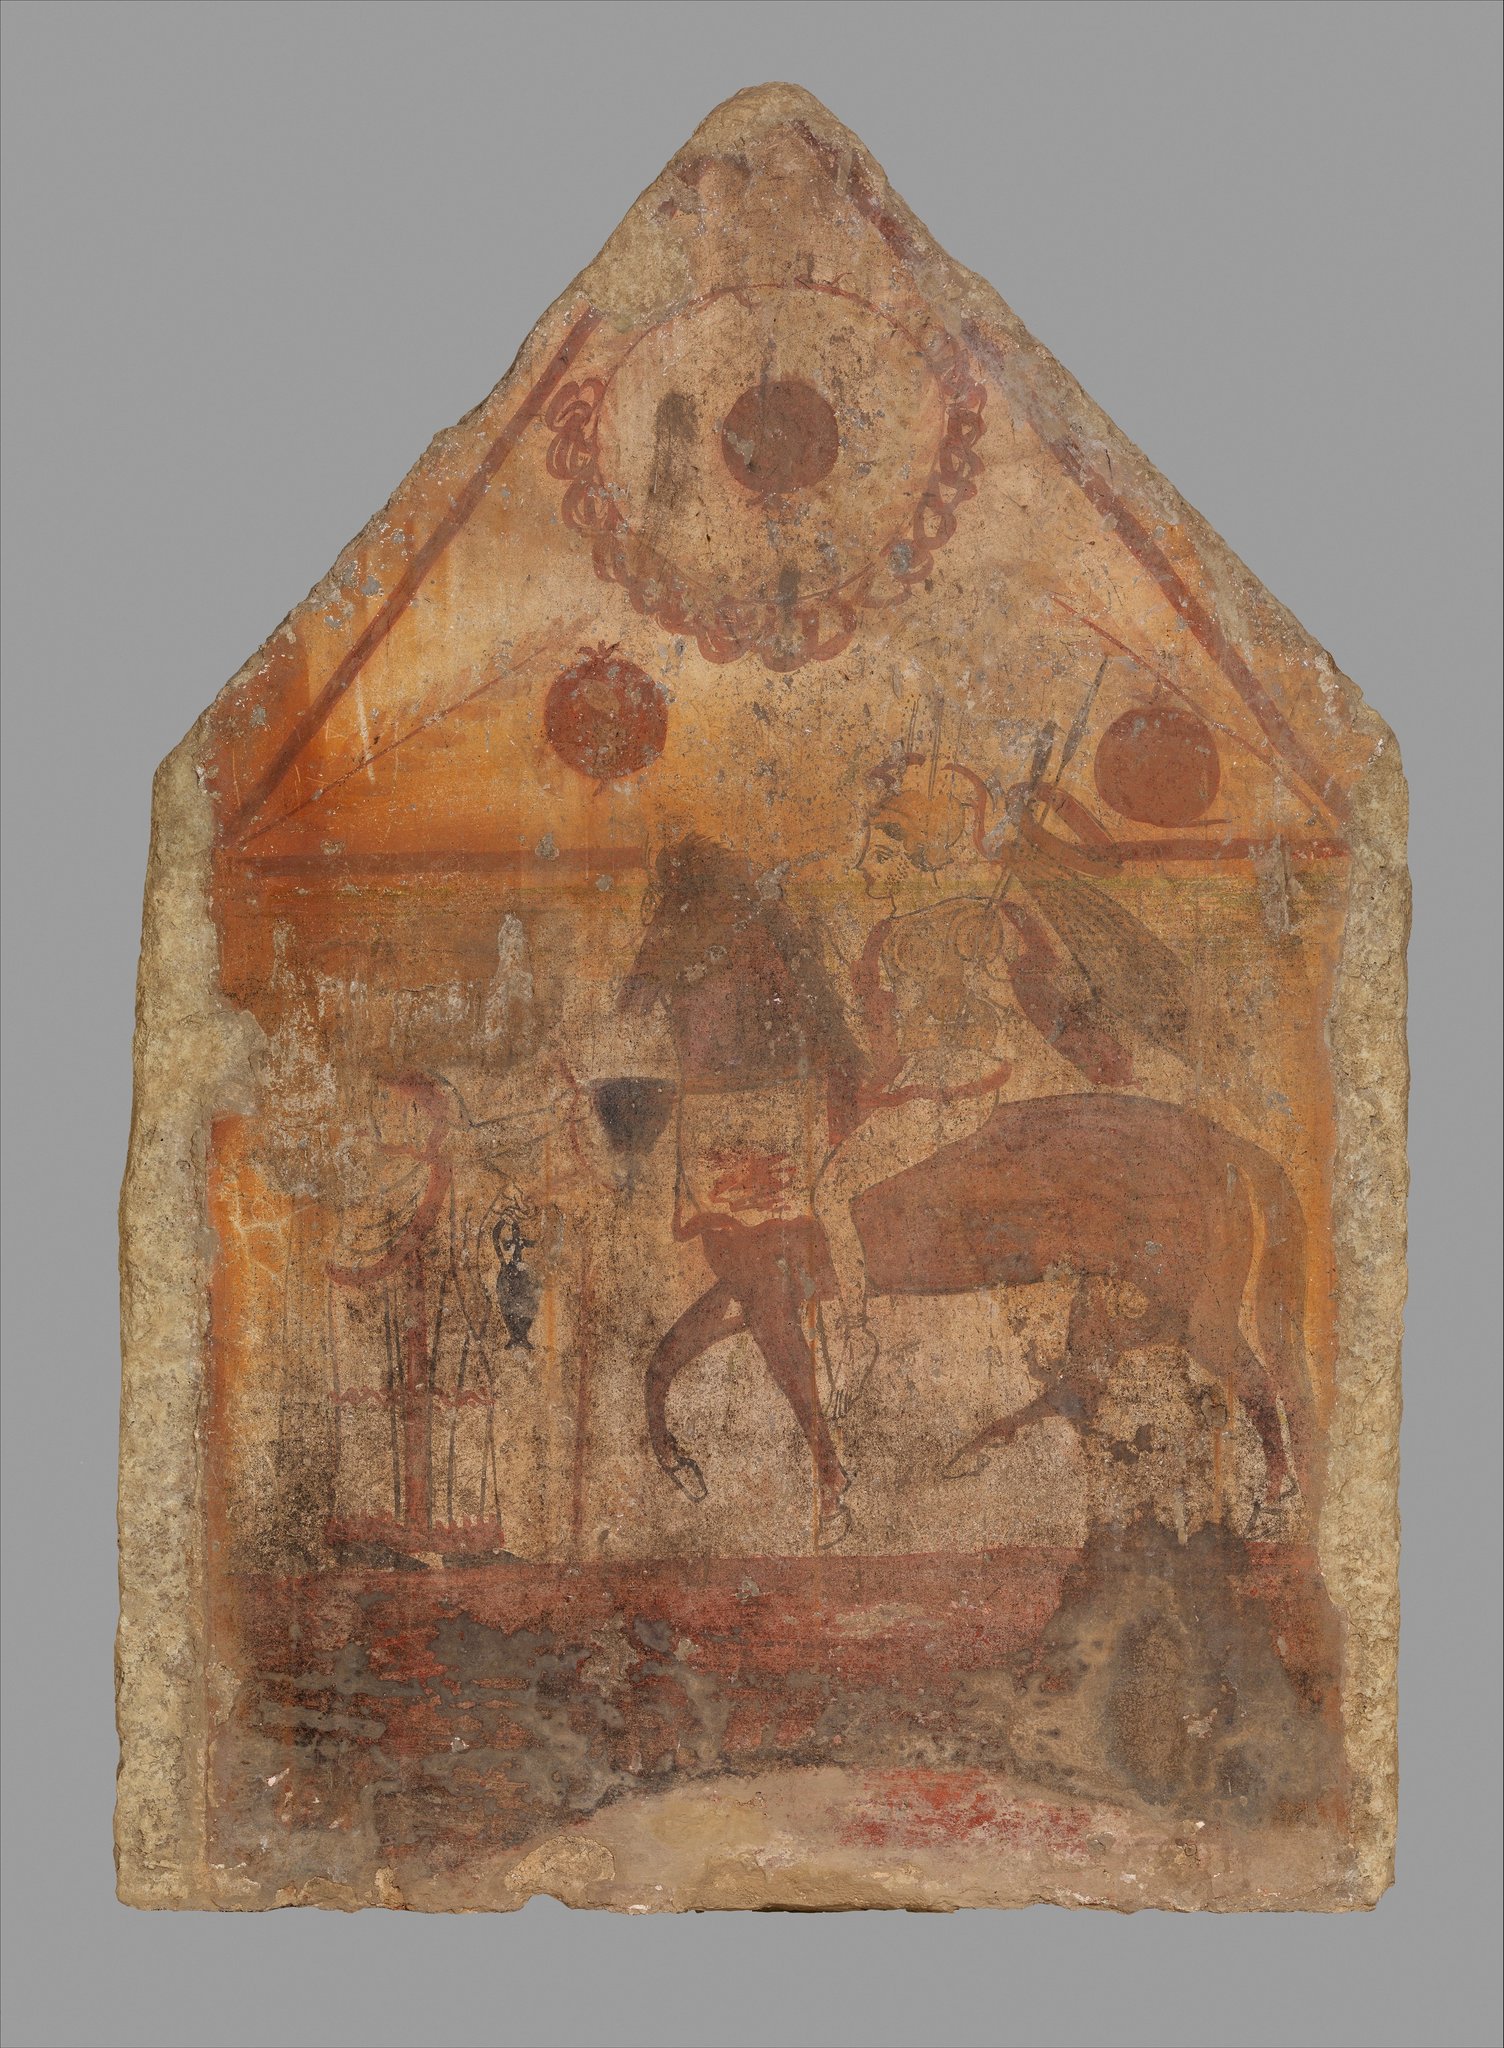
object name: wall painting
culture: greek, south italian, lucanian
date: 367-335 BCE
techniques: fresco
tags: pomegranates,women,horses,warriors